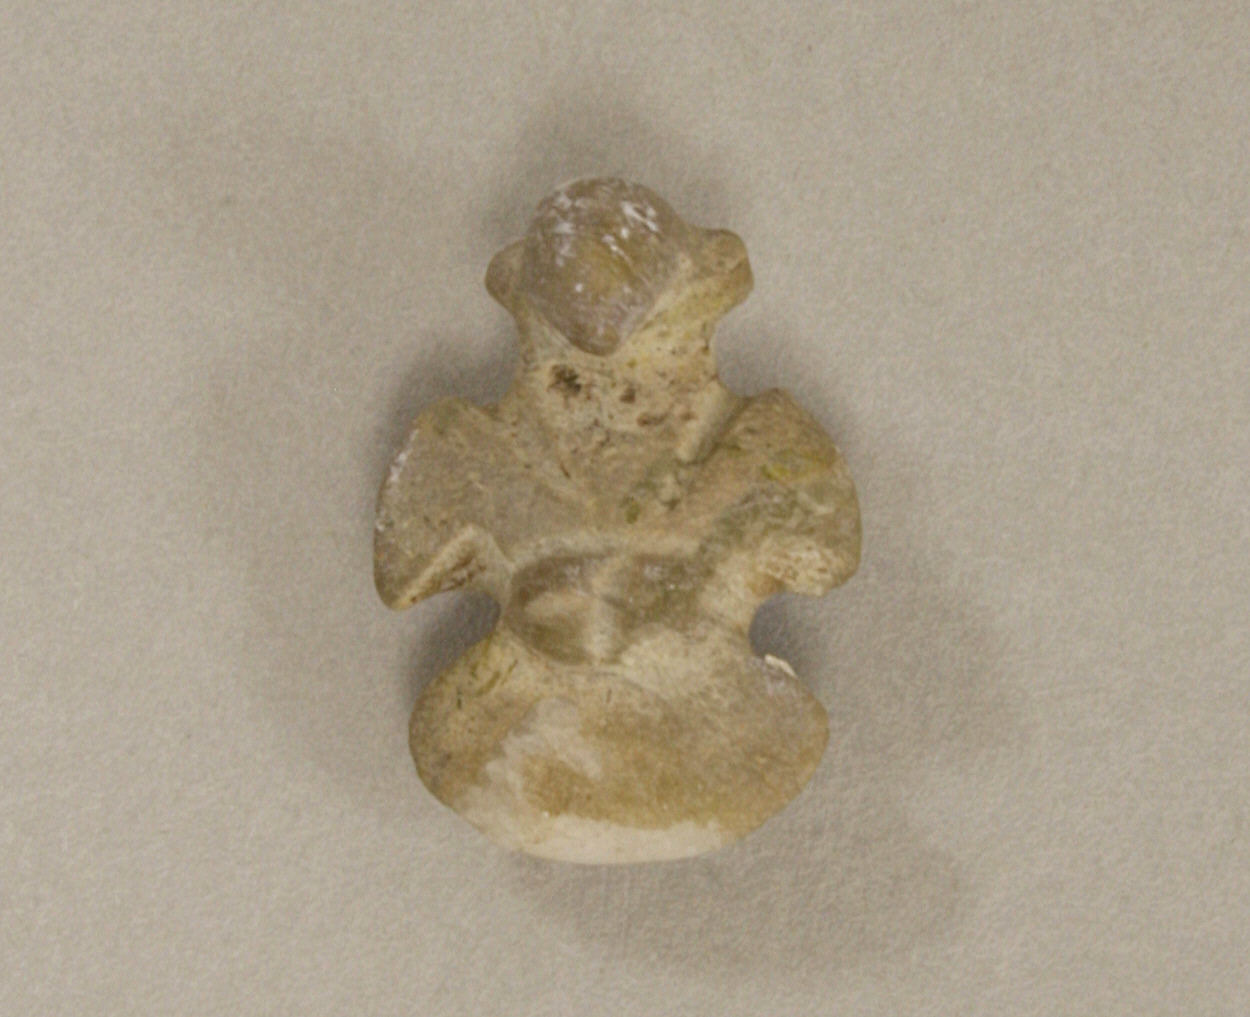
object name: ornament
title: Bird Ornament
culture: atlantic watershed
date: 1001-1600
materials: stone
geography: costa rica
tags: birds